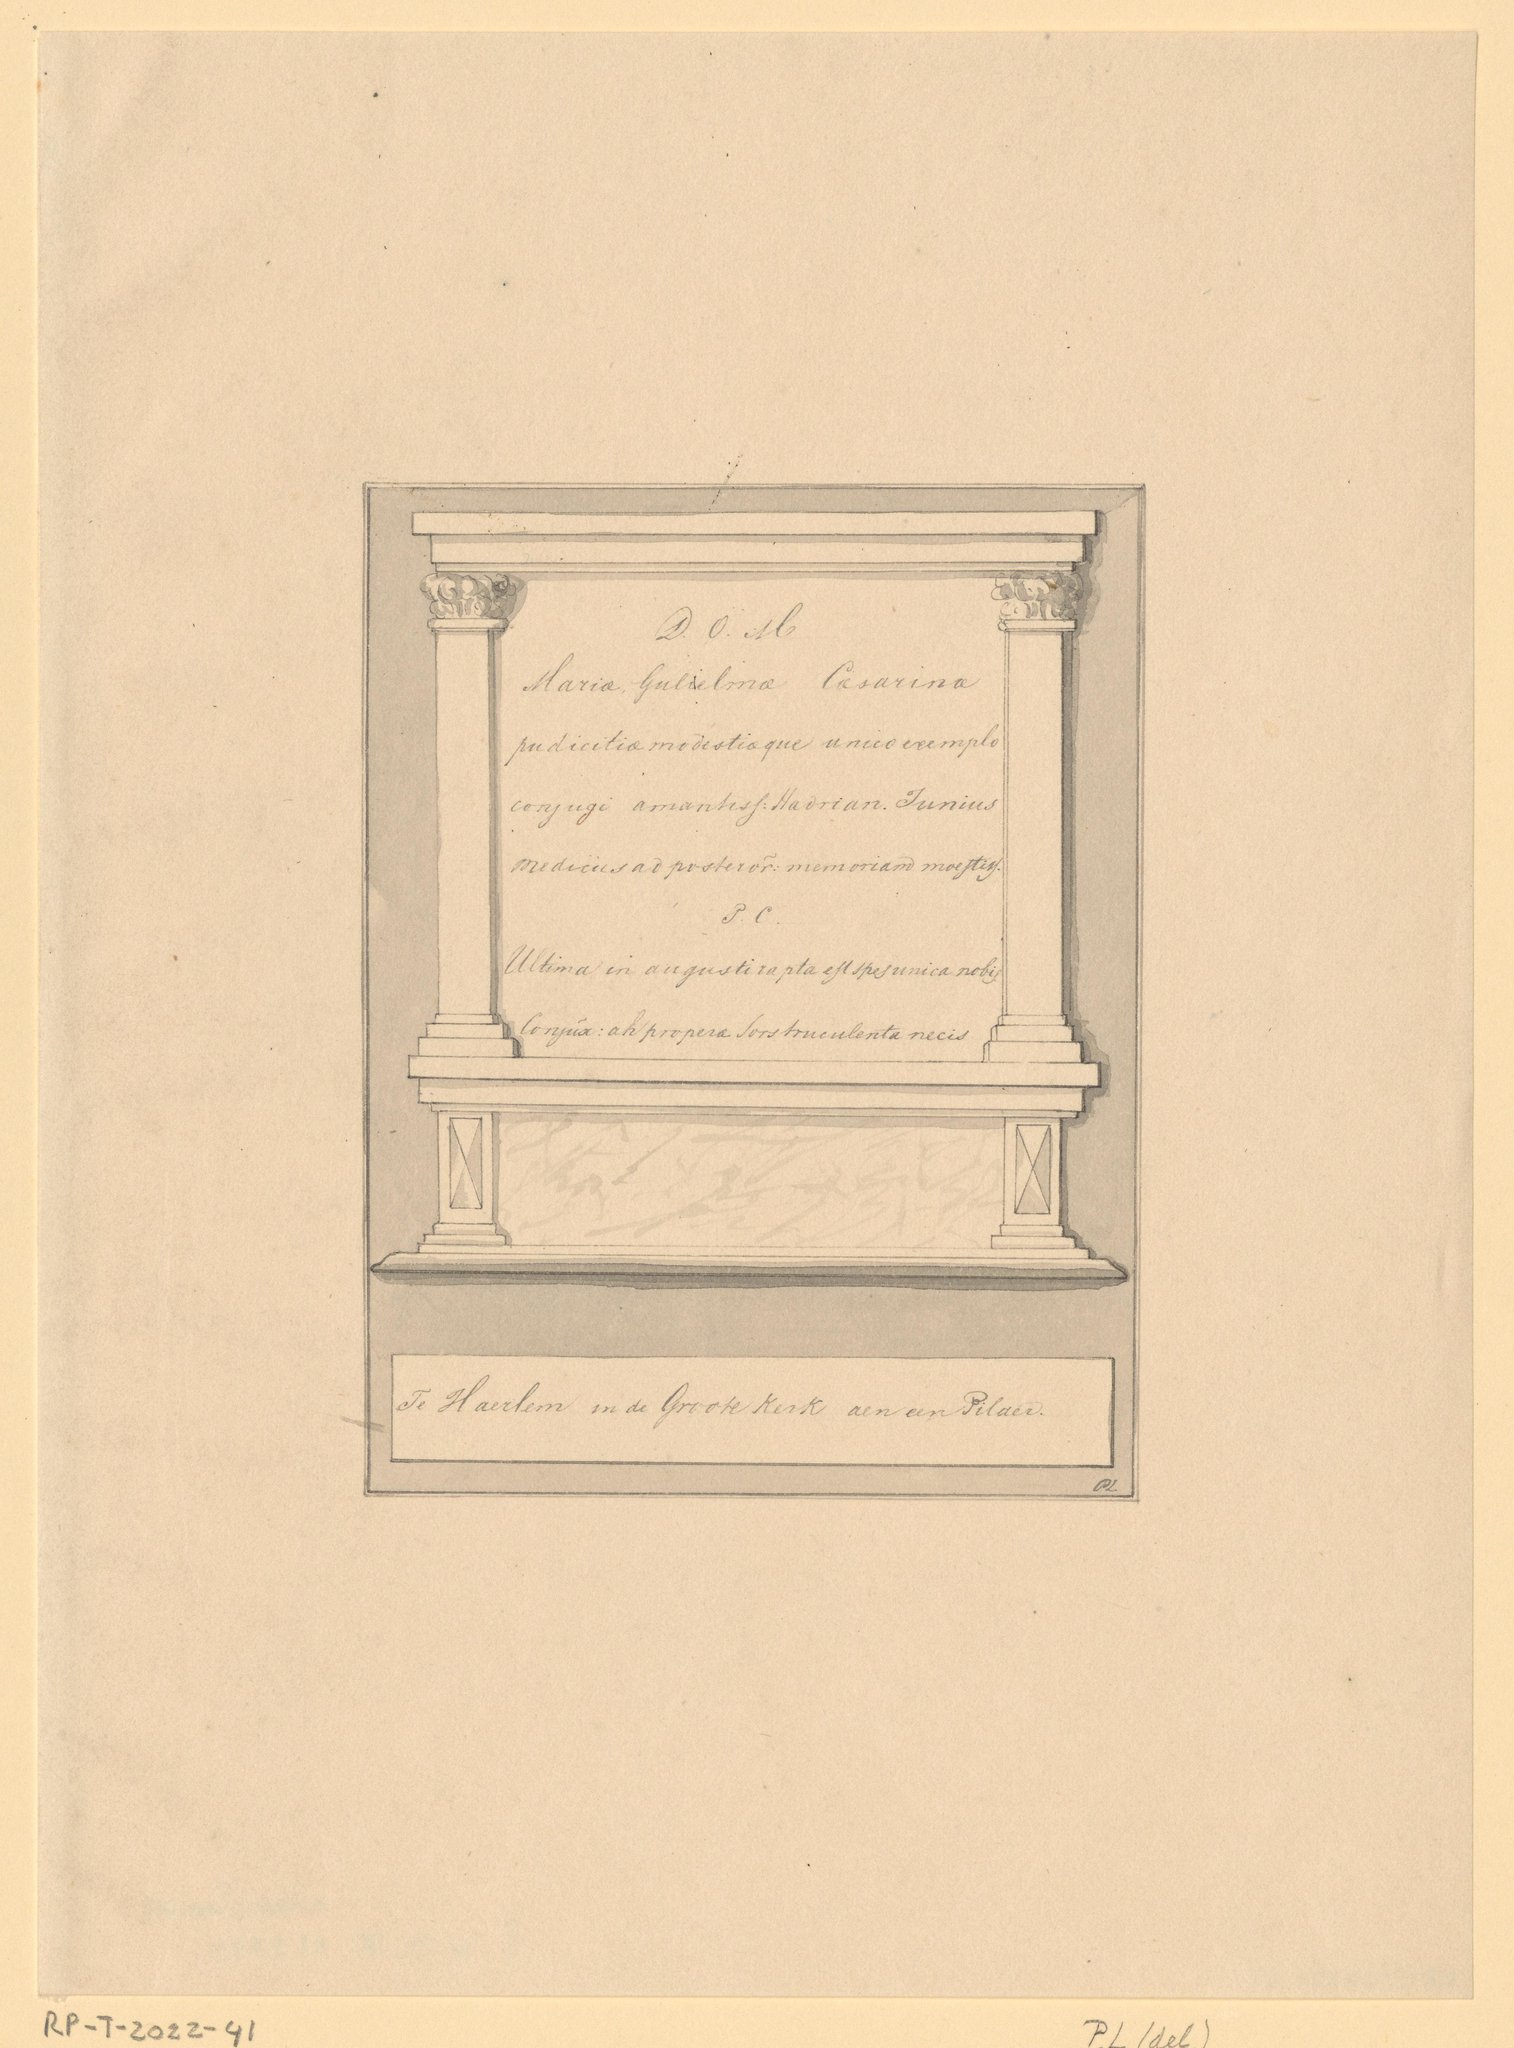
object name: drawing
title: Herdenkingsmonument voor Maria Wilhelmina Keizers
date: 1800-1899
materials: ink, paper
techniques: brush, pen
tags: historical persons - bb - woman, other memorial structures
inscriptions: monogram: ‘PL’